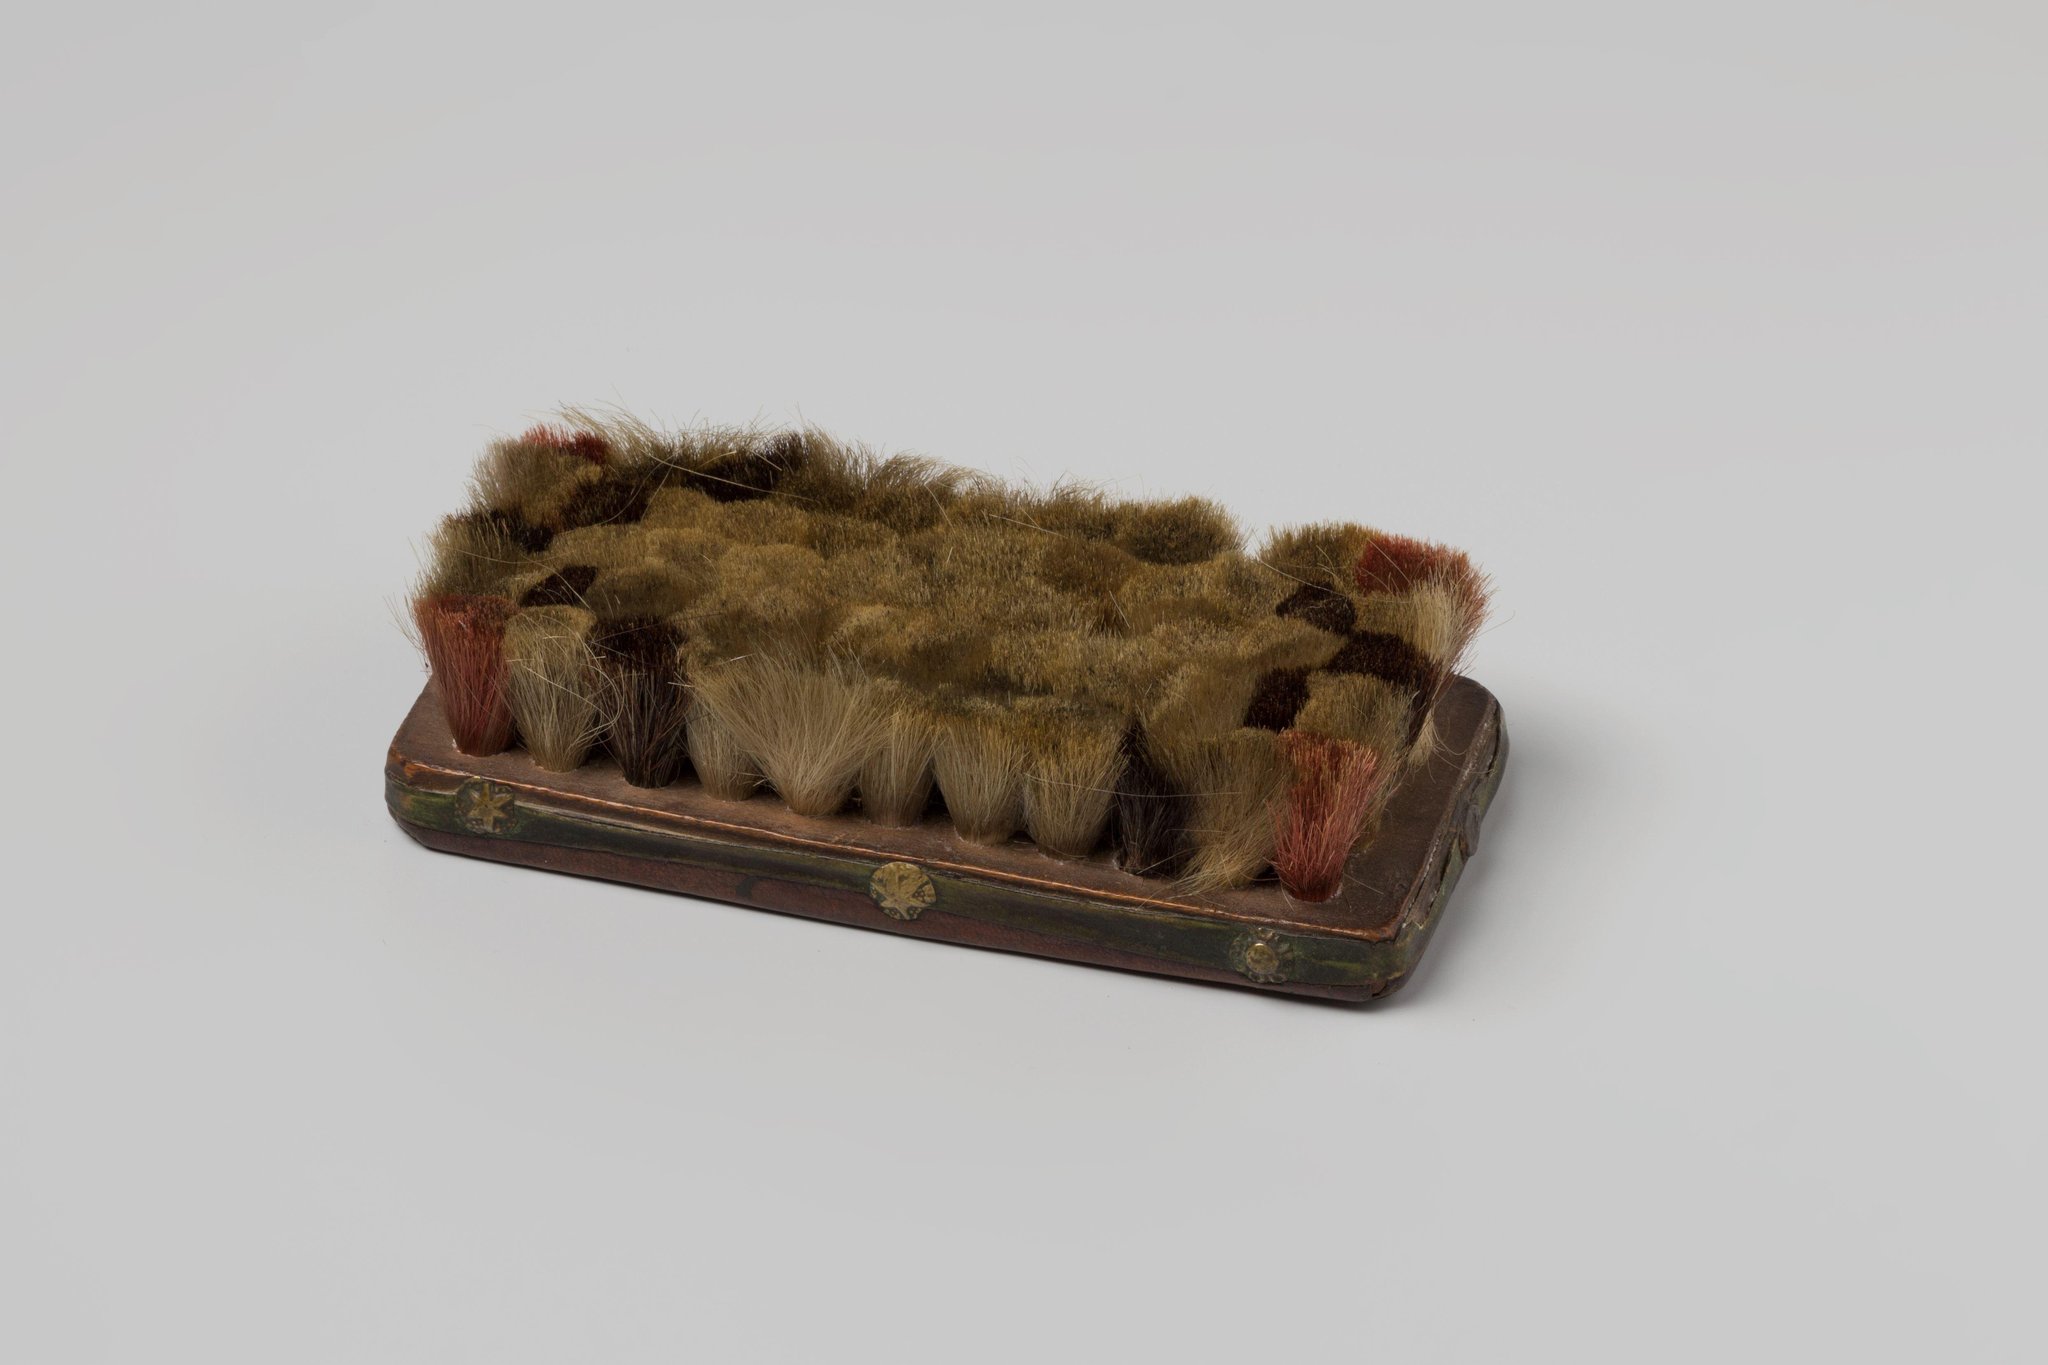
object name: brush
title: Borstel voor huishouden, met leer overtrokken rug en gele, zwarte en rode zachte haren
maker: Anonymous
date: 1600-1800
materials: copper, hair, leather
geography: europe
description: Een borstel. De rug met bruin leer overtrokken en met zeven koperen sterretjes versierd. Zwart, geel en rood zeer zacht haar.